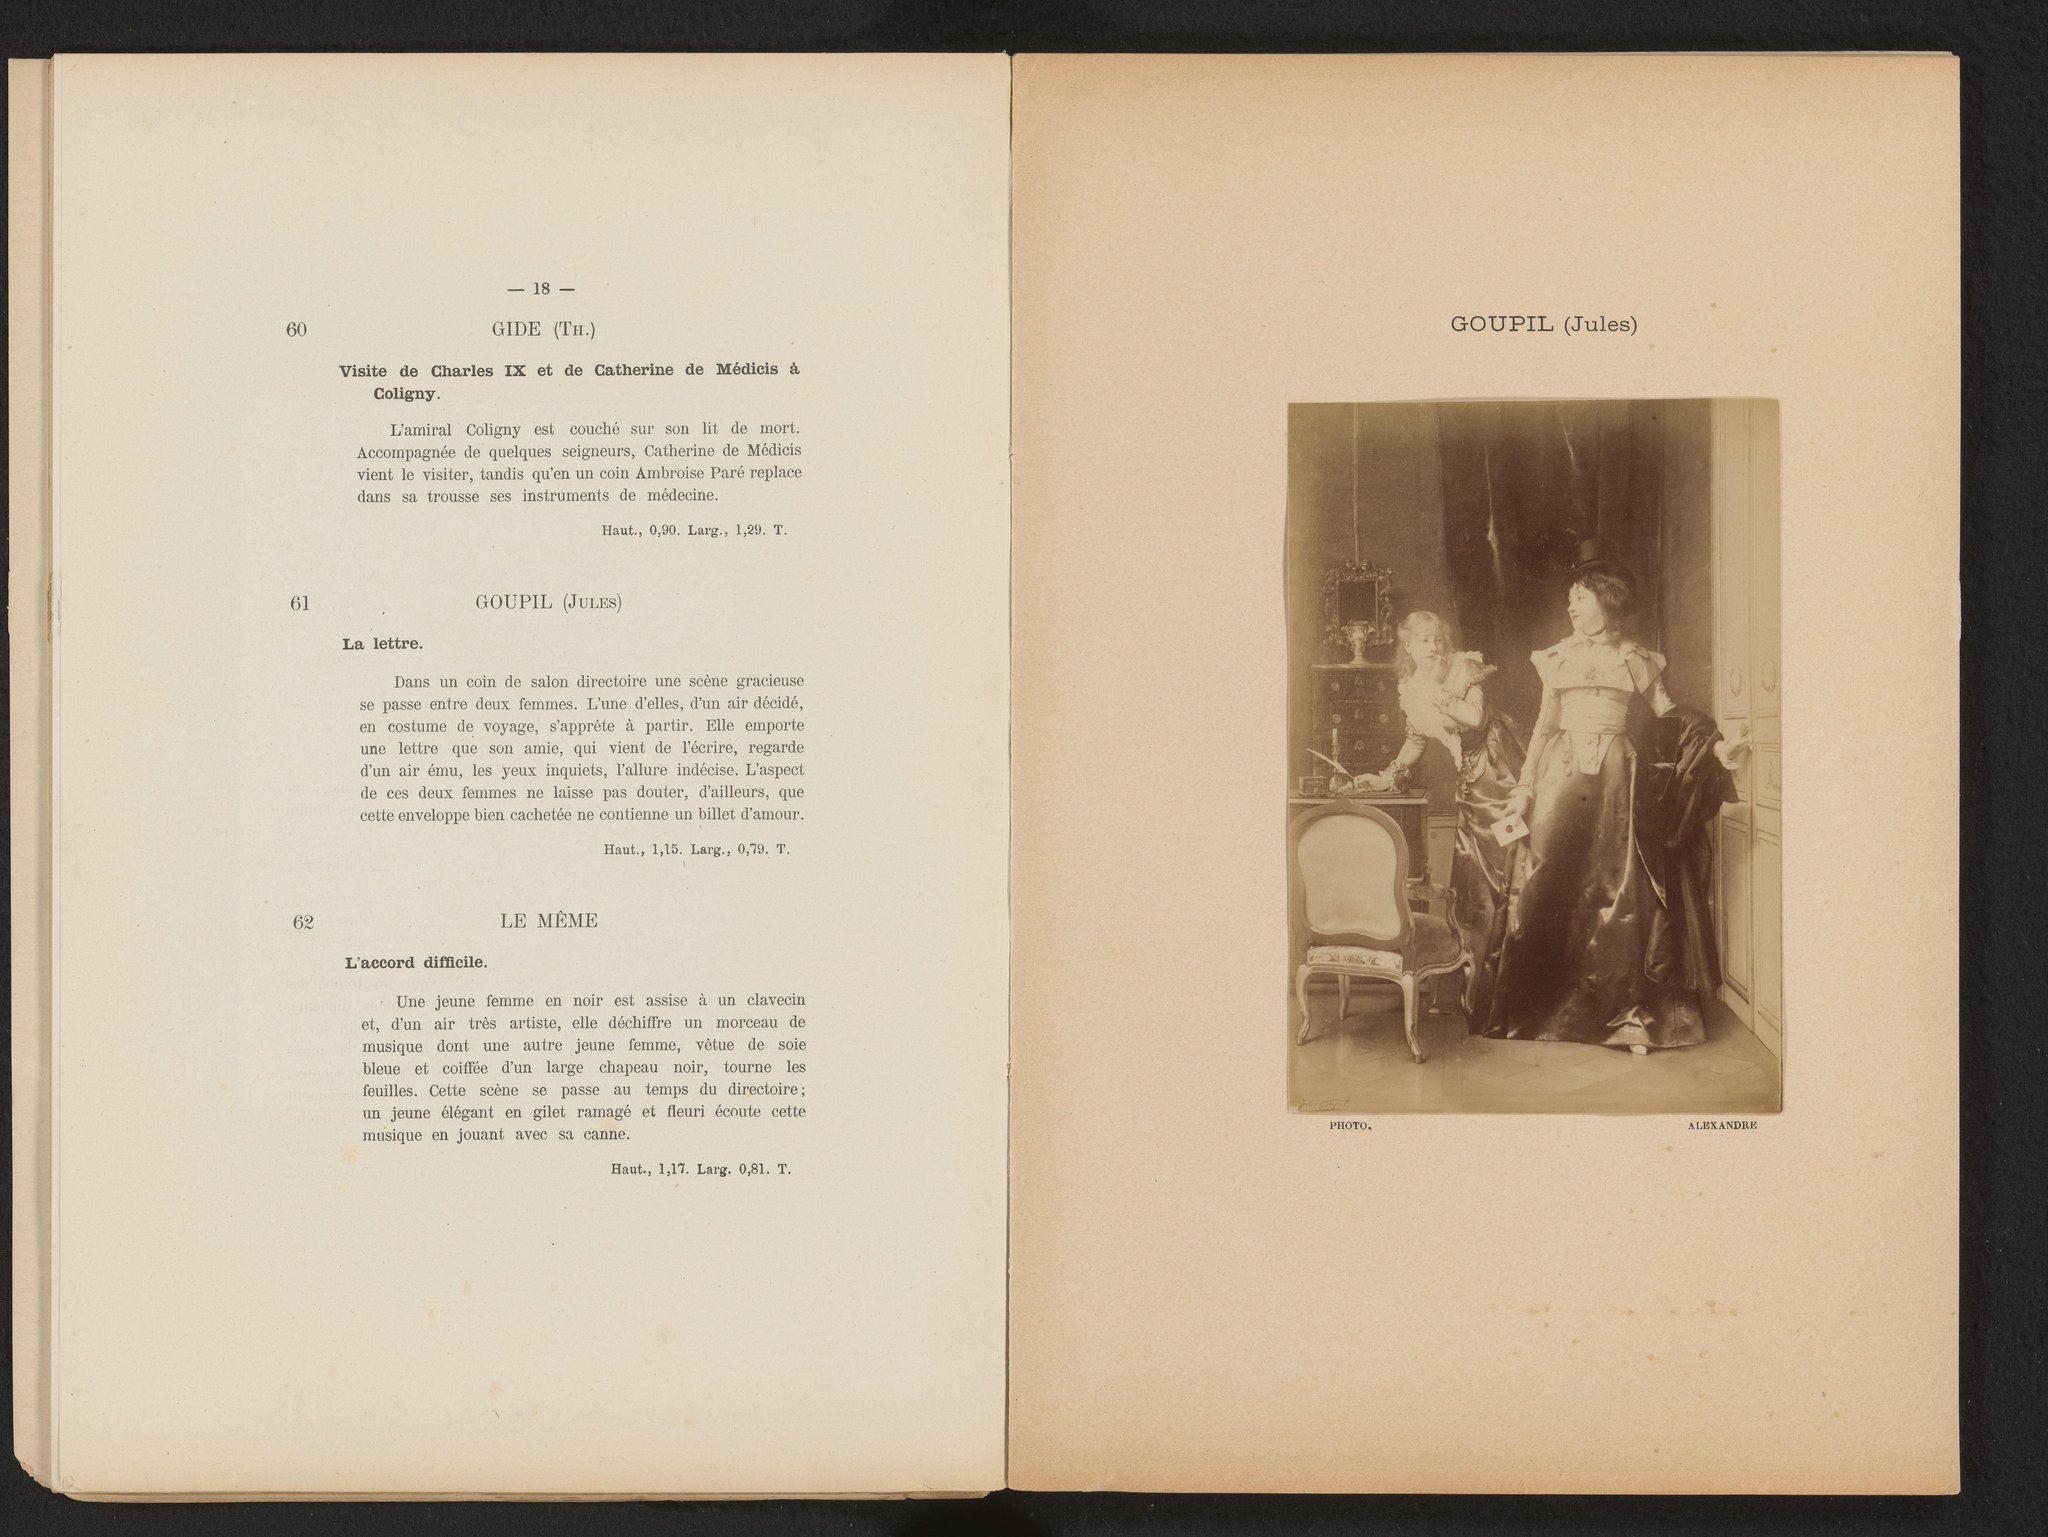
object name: reproduction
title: Goupil (Jules)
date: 1888-1893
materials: photographic support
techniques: albumen print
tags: adult man, painting, drawing and the graphic arts